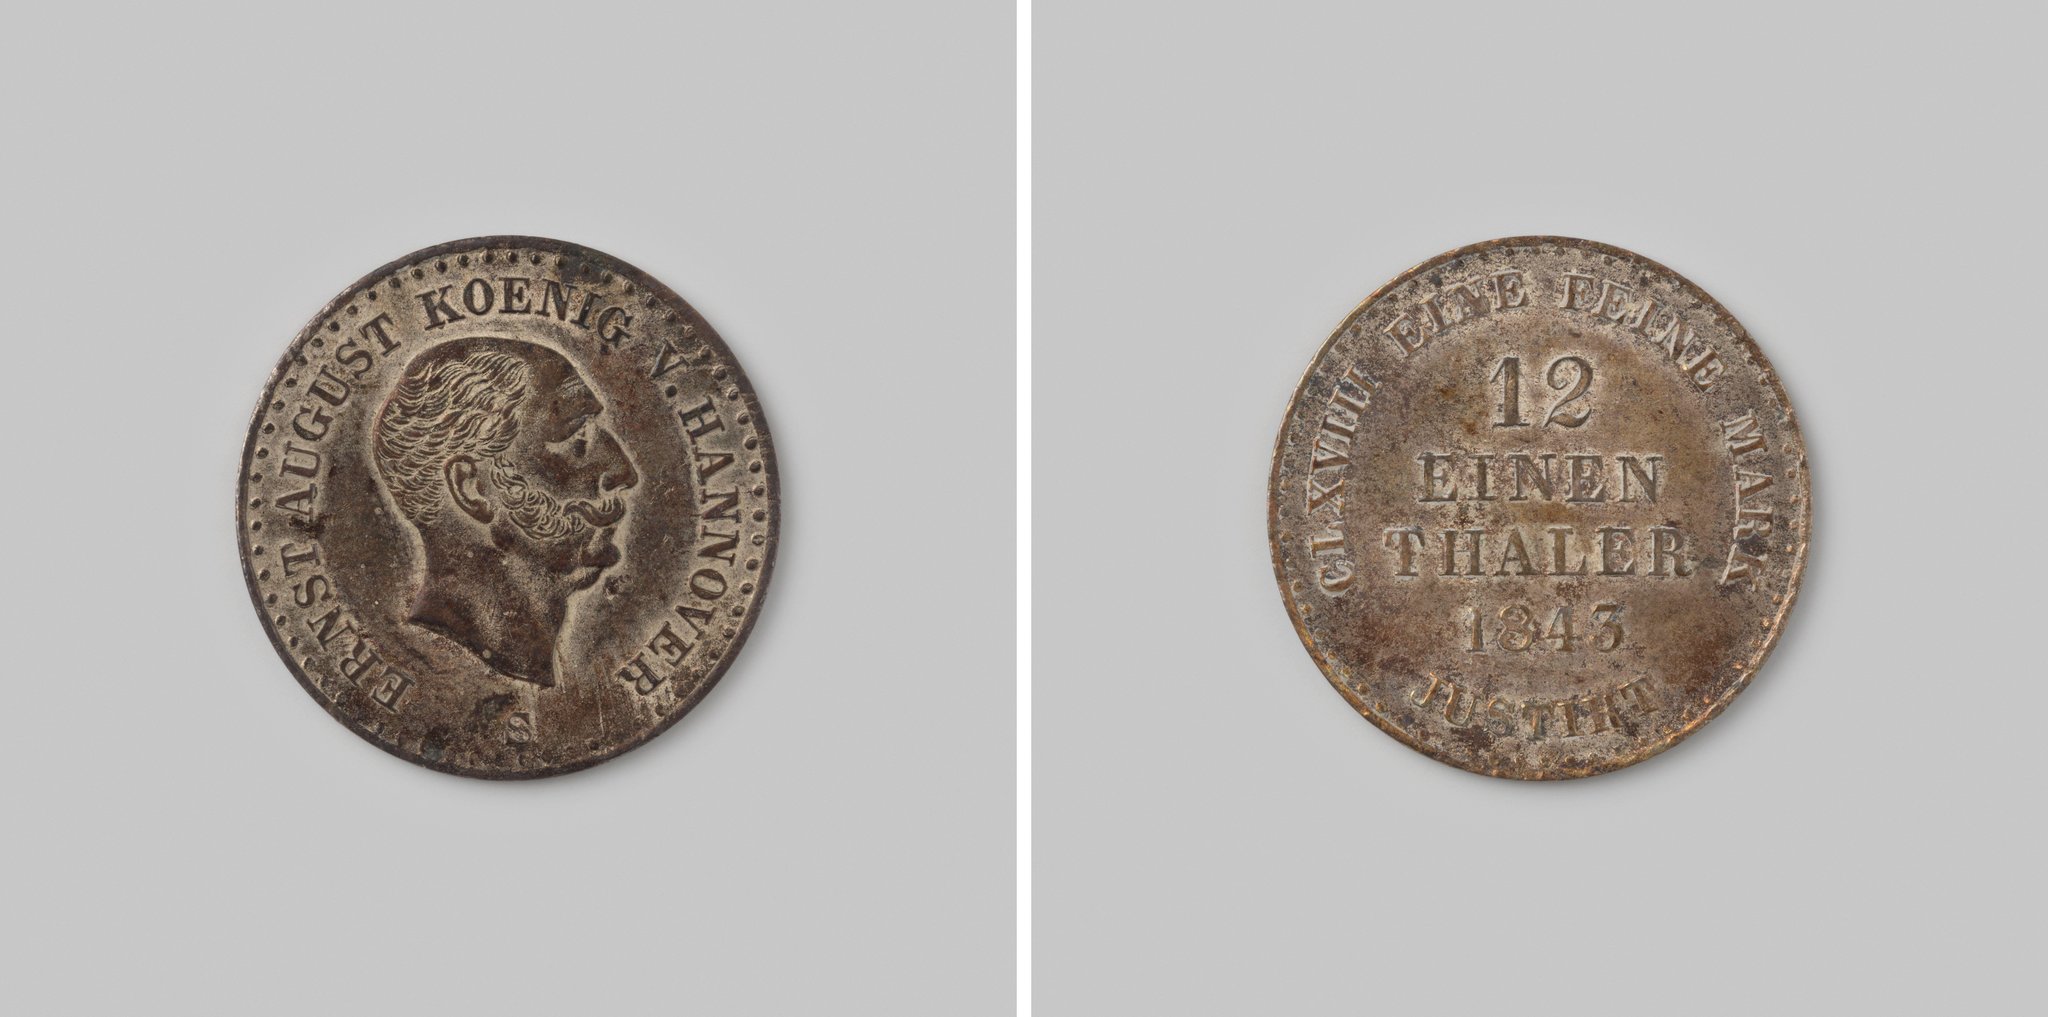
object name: twaalfde taler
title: Koninkrijk Hannover, Ernst August, 1/12 Taler, 1843 S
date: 1843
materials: silver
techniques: striking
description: Zilveren munt. Voorzijde: hoofd van de koning naar rechts. Daaronder letter S. Keerzijde: waarde-aanduiding in drie regels, waaronder jaartal. Kartelrand.